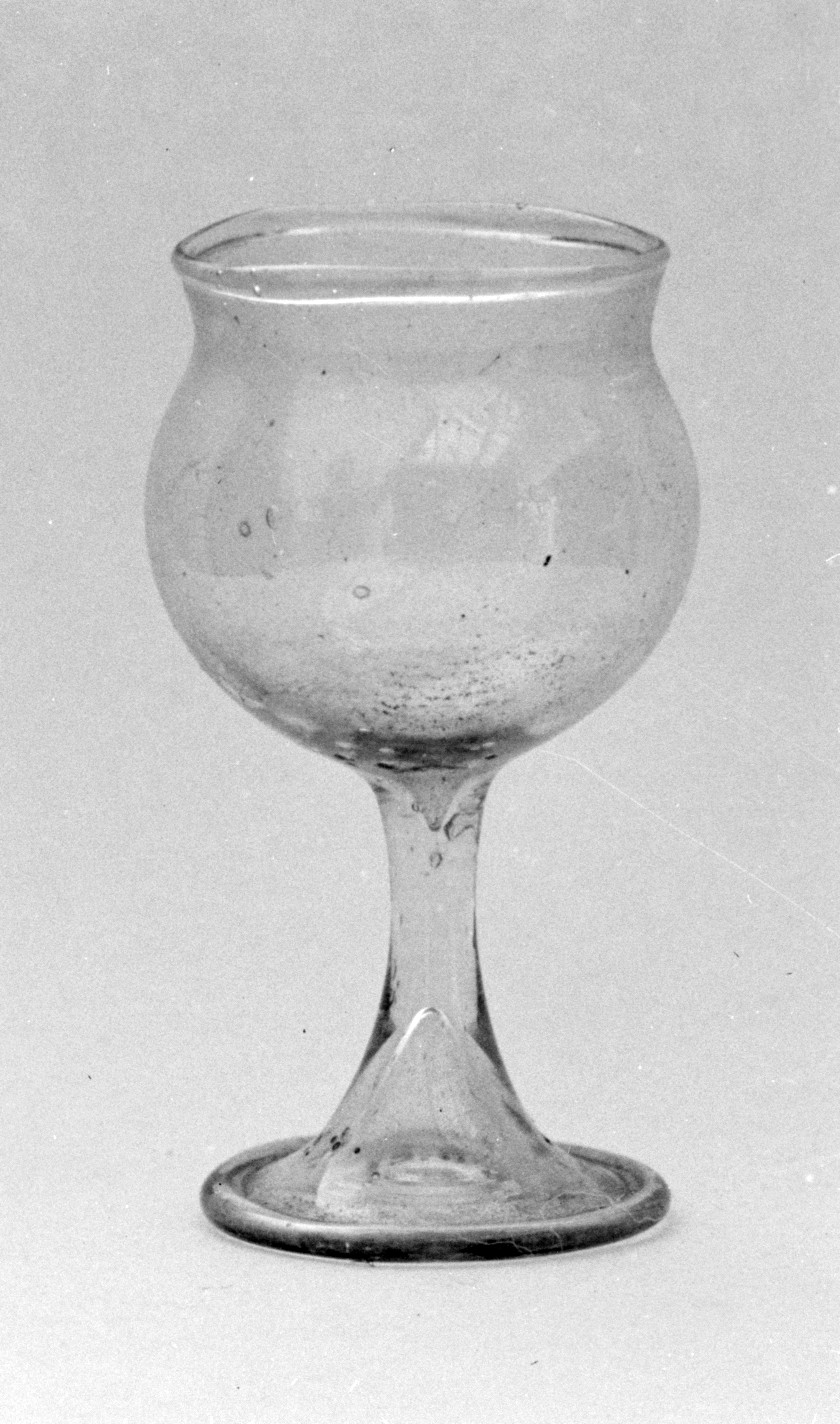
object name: goblet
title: Miniature goblet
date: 1701-1900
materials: glass